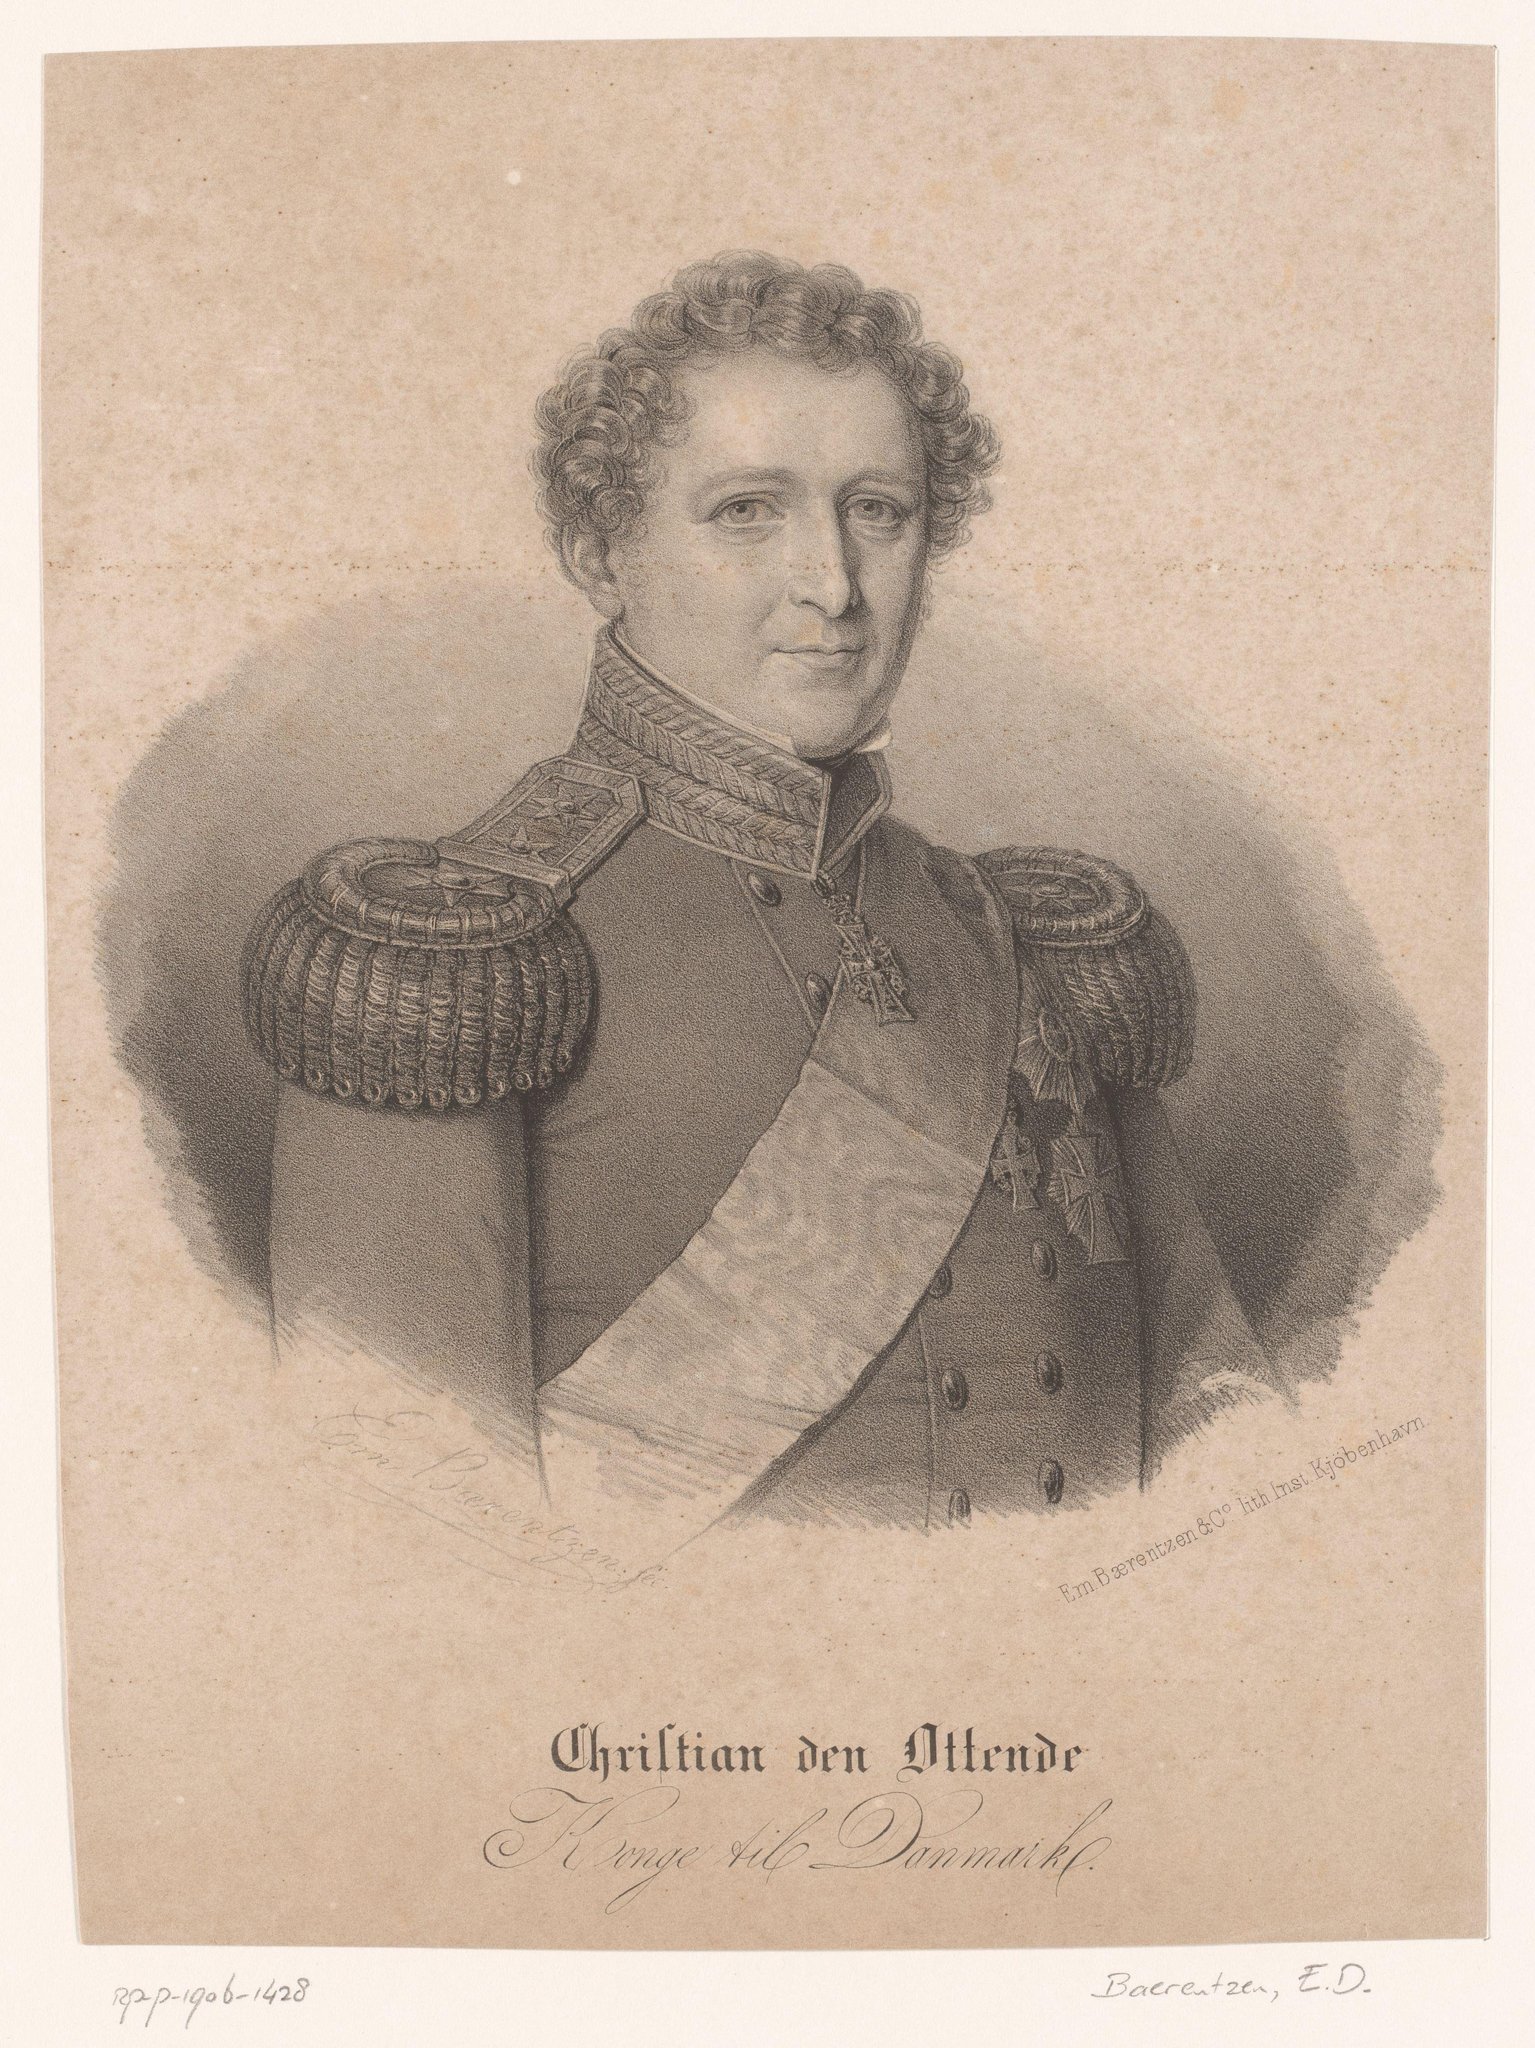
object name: print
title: Portret van Koning Christian VIII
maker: emilius ditlev baerentzen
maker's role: print maker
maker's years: 1799-1868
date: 1837-1868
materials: paper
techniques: lithograph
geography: copenhagen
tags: copenhagen (city), historical persons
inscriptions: inscription: ‘Em. Baerentzen & Co. lith.Inst. Kjöbenhavn’, inscription: ‘Christian den Ottende / Konge til Danmark.’, inscription: ‘Em Baerentzen. fec.’, collector's mark: Lugt 2228